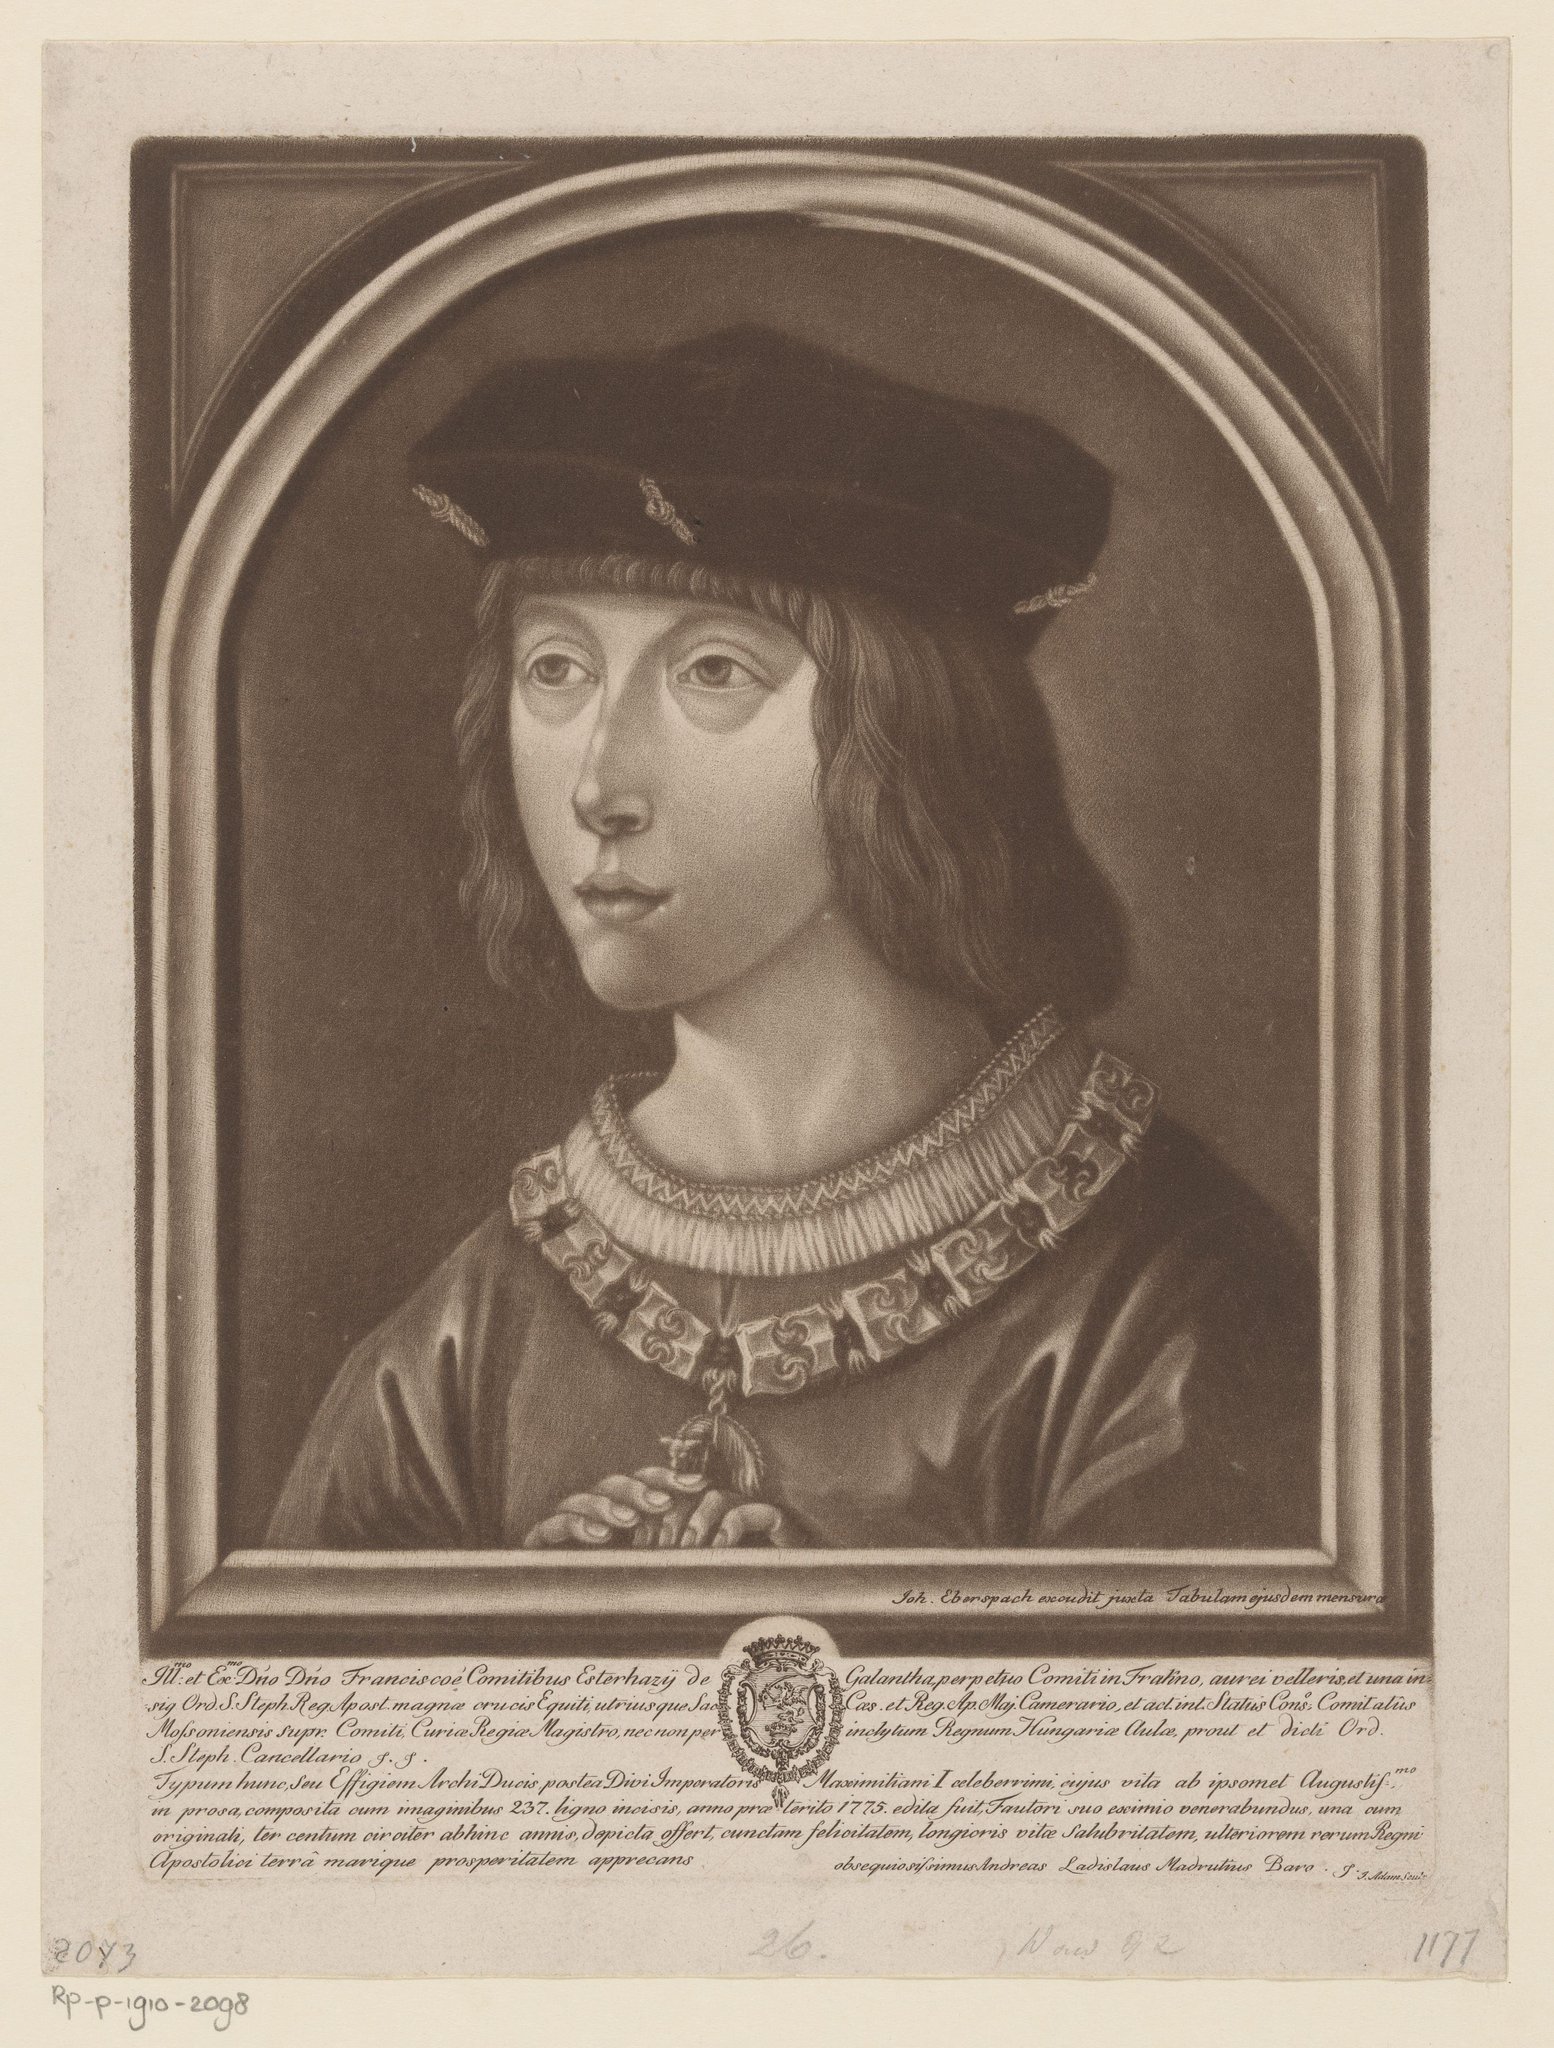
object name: print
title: Portret van keizer Maximiliaan I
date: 1770-1780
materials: paper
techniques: mezzotint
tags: maximilian i (holy roman emperor), historical persons, emperor, knighthood order of the golden fleece - insignia of a knighthood order, e.g.: badge, chain (with name of order), armorial bearing, heraldry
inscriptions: collector's mark: Lugt 2228